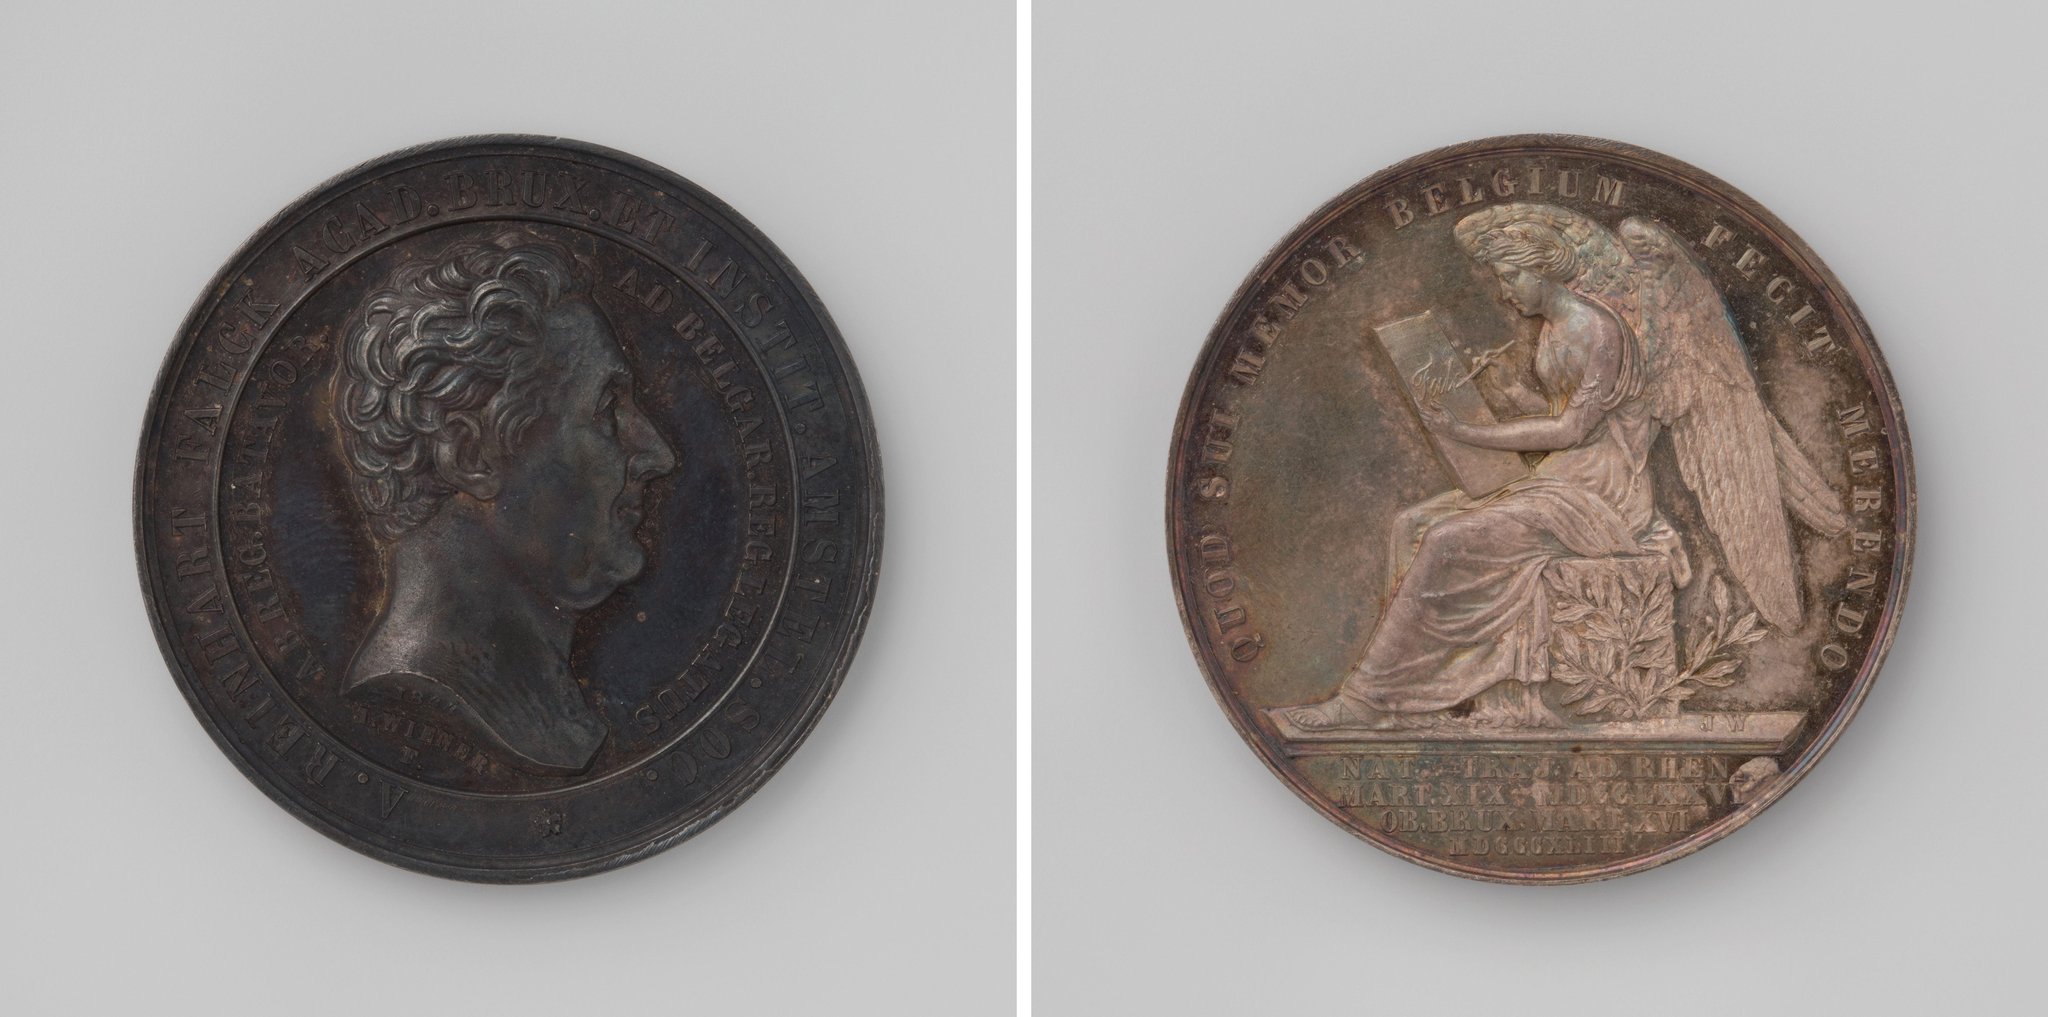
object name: history medal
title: Overlijden van Anton Reinhard Falck, afgezant van de koning der Nederlanden in België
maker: jacob wiener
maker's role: medailleur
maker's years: 1815-1899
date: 1844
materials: silver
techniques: striking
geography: brussels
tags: anton reinhard falck, belgium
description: Zilveren penning. Voorzijde: borststuk man binnen omschrift. Keerzijde: gevleugelde vrouw, voorstellende Geschiedenis, zit op rotsblok, waartegen olijventakken groeien en schrijft naam van Falck op een tafel binnen omschrift; afsnede: opschrift.